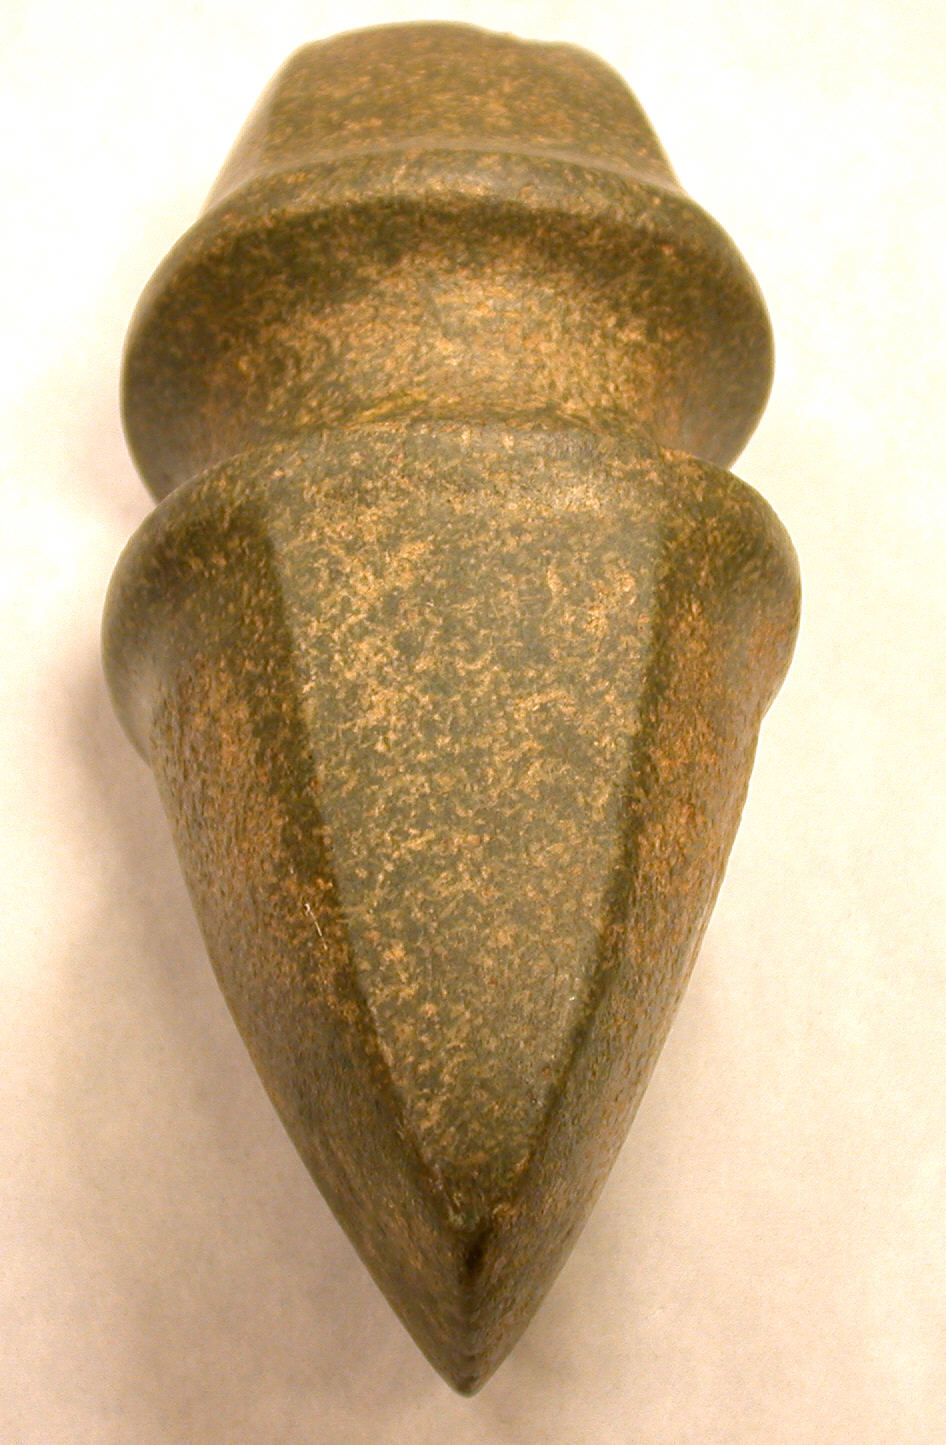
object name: knife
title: Pointed Stone Blade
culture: woodland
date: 1501-1600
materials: stone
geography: united states